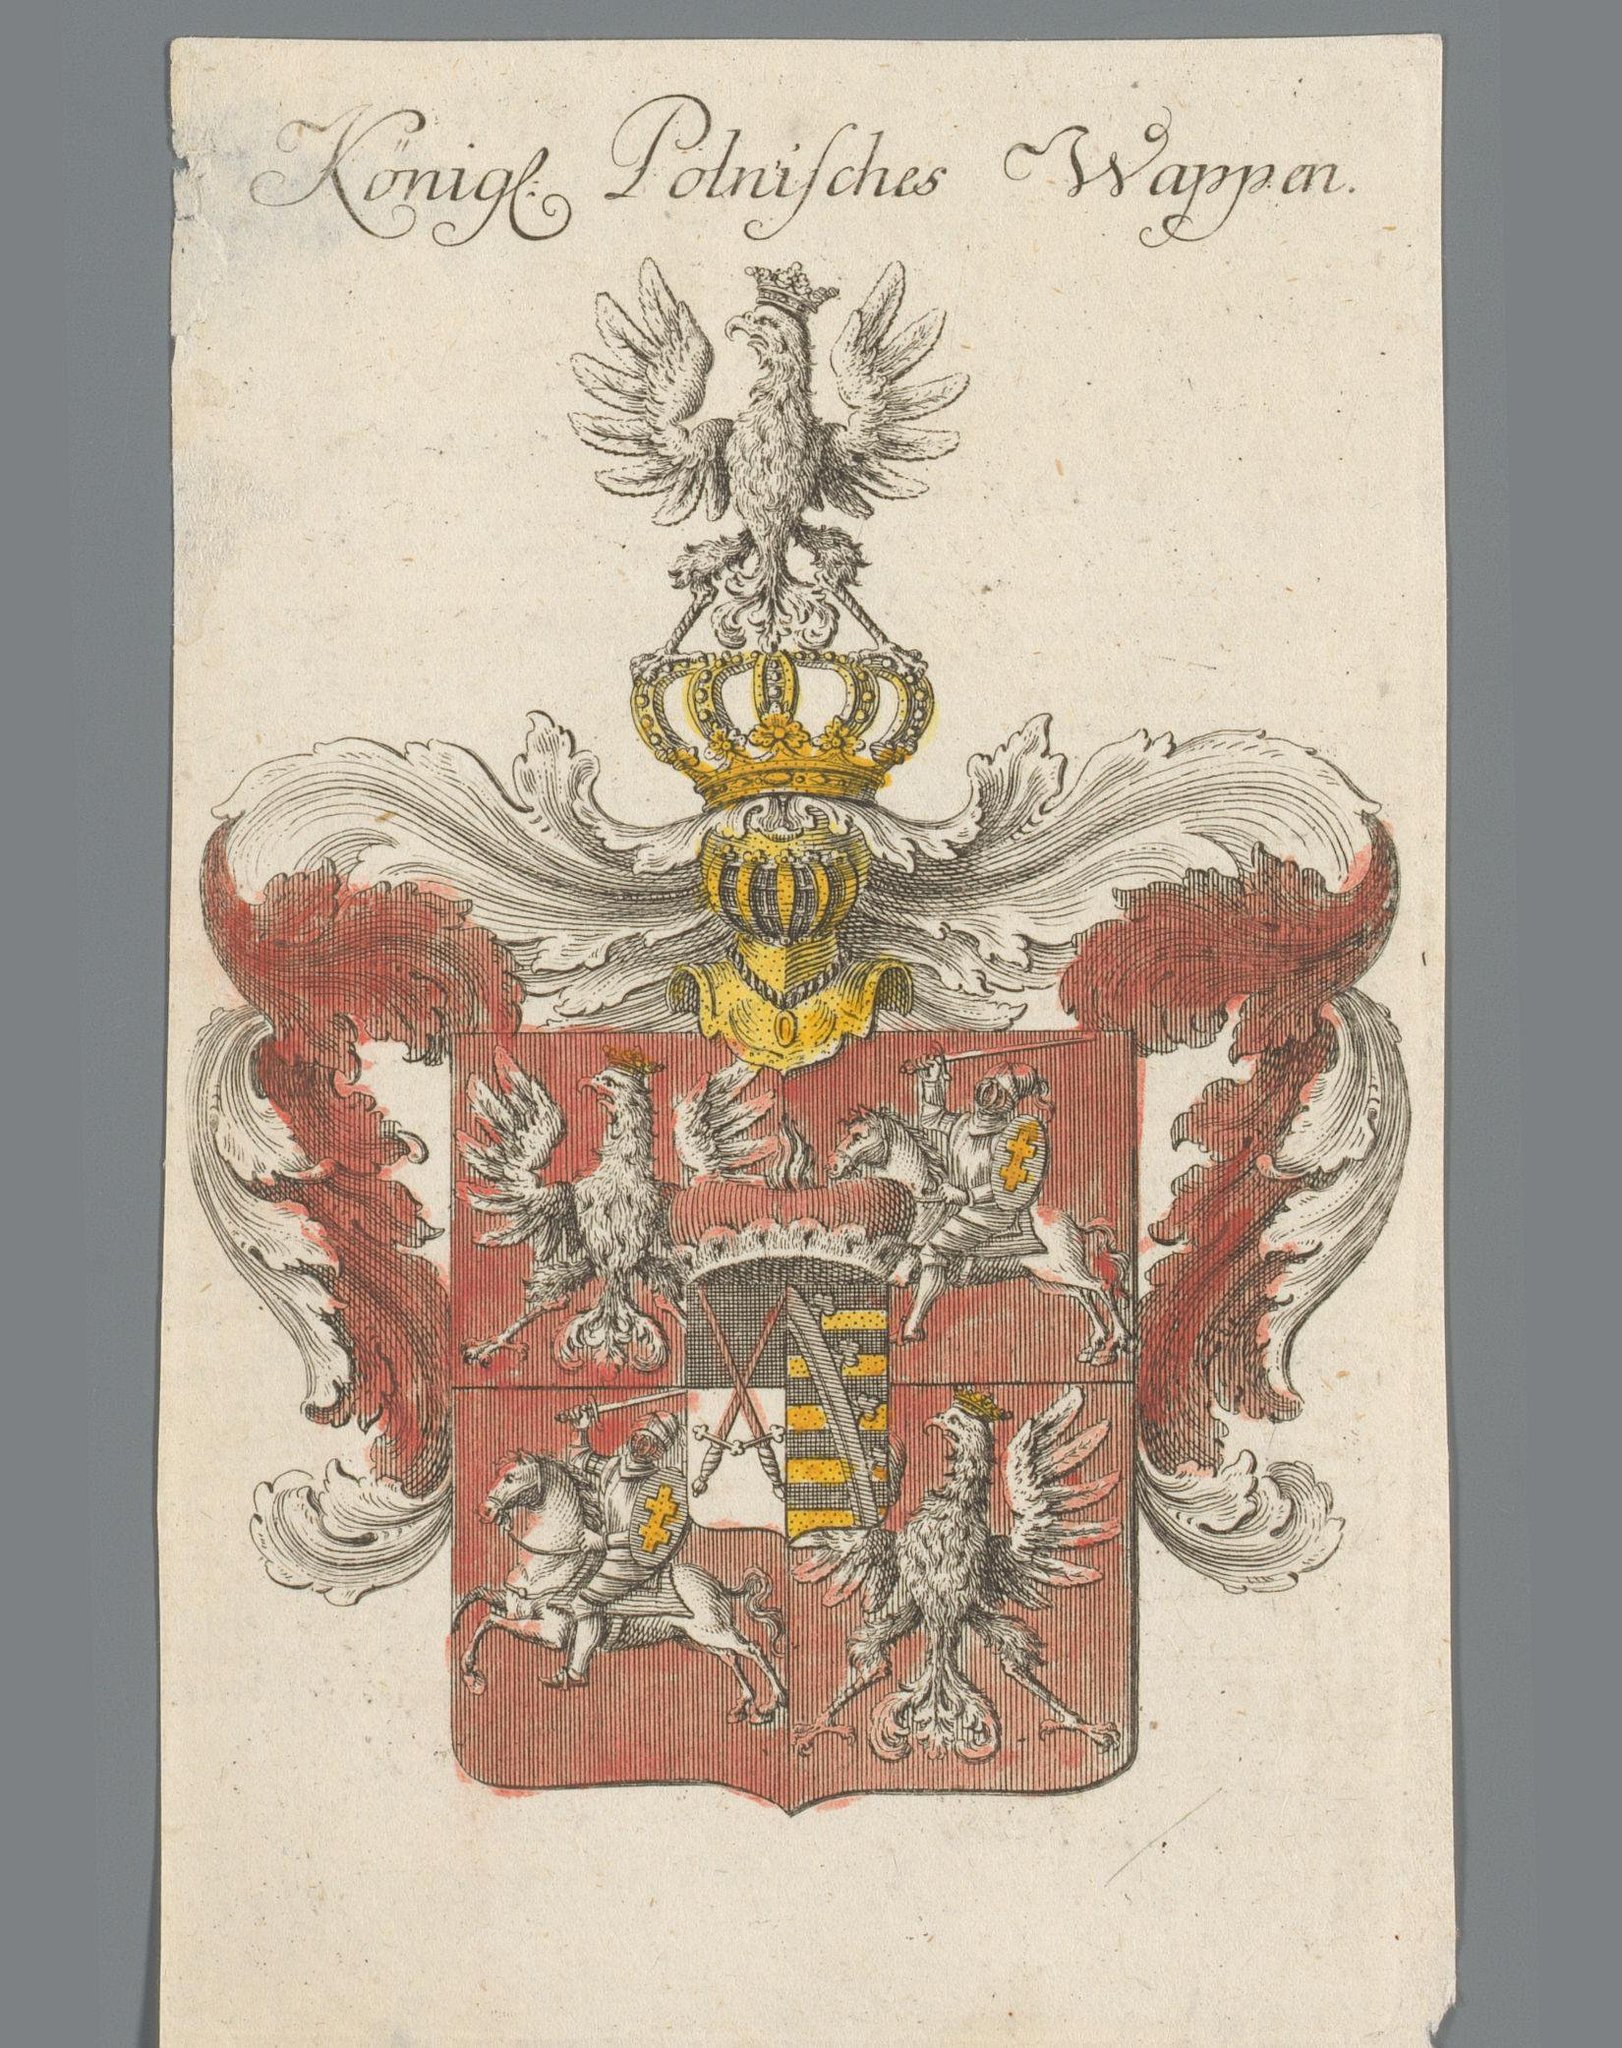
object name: book illustration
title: Königl. Polisches Wappen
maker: Anonymous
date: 1736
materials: paper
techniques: engraving, hand coloring, letterpress printing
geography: nuremberg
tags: riding a horse, ass, or mule; rider, horseman, predatory birds: eagle, armorial bearing, heraldry, poland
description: Prent uit: Der durchlauchtigen Welt (...) Geschichts-Geschlechts- und Wappen-Kalender (...). Neurenberg: erven Christoph Weigel, 1736.